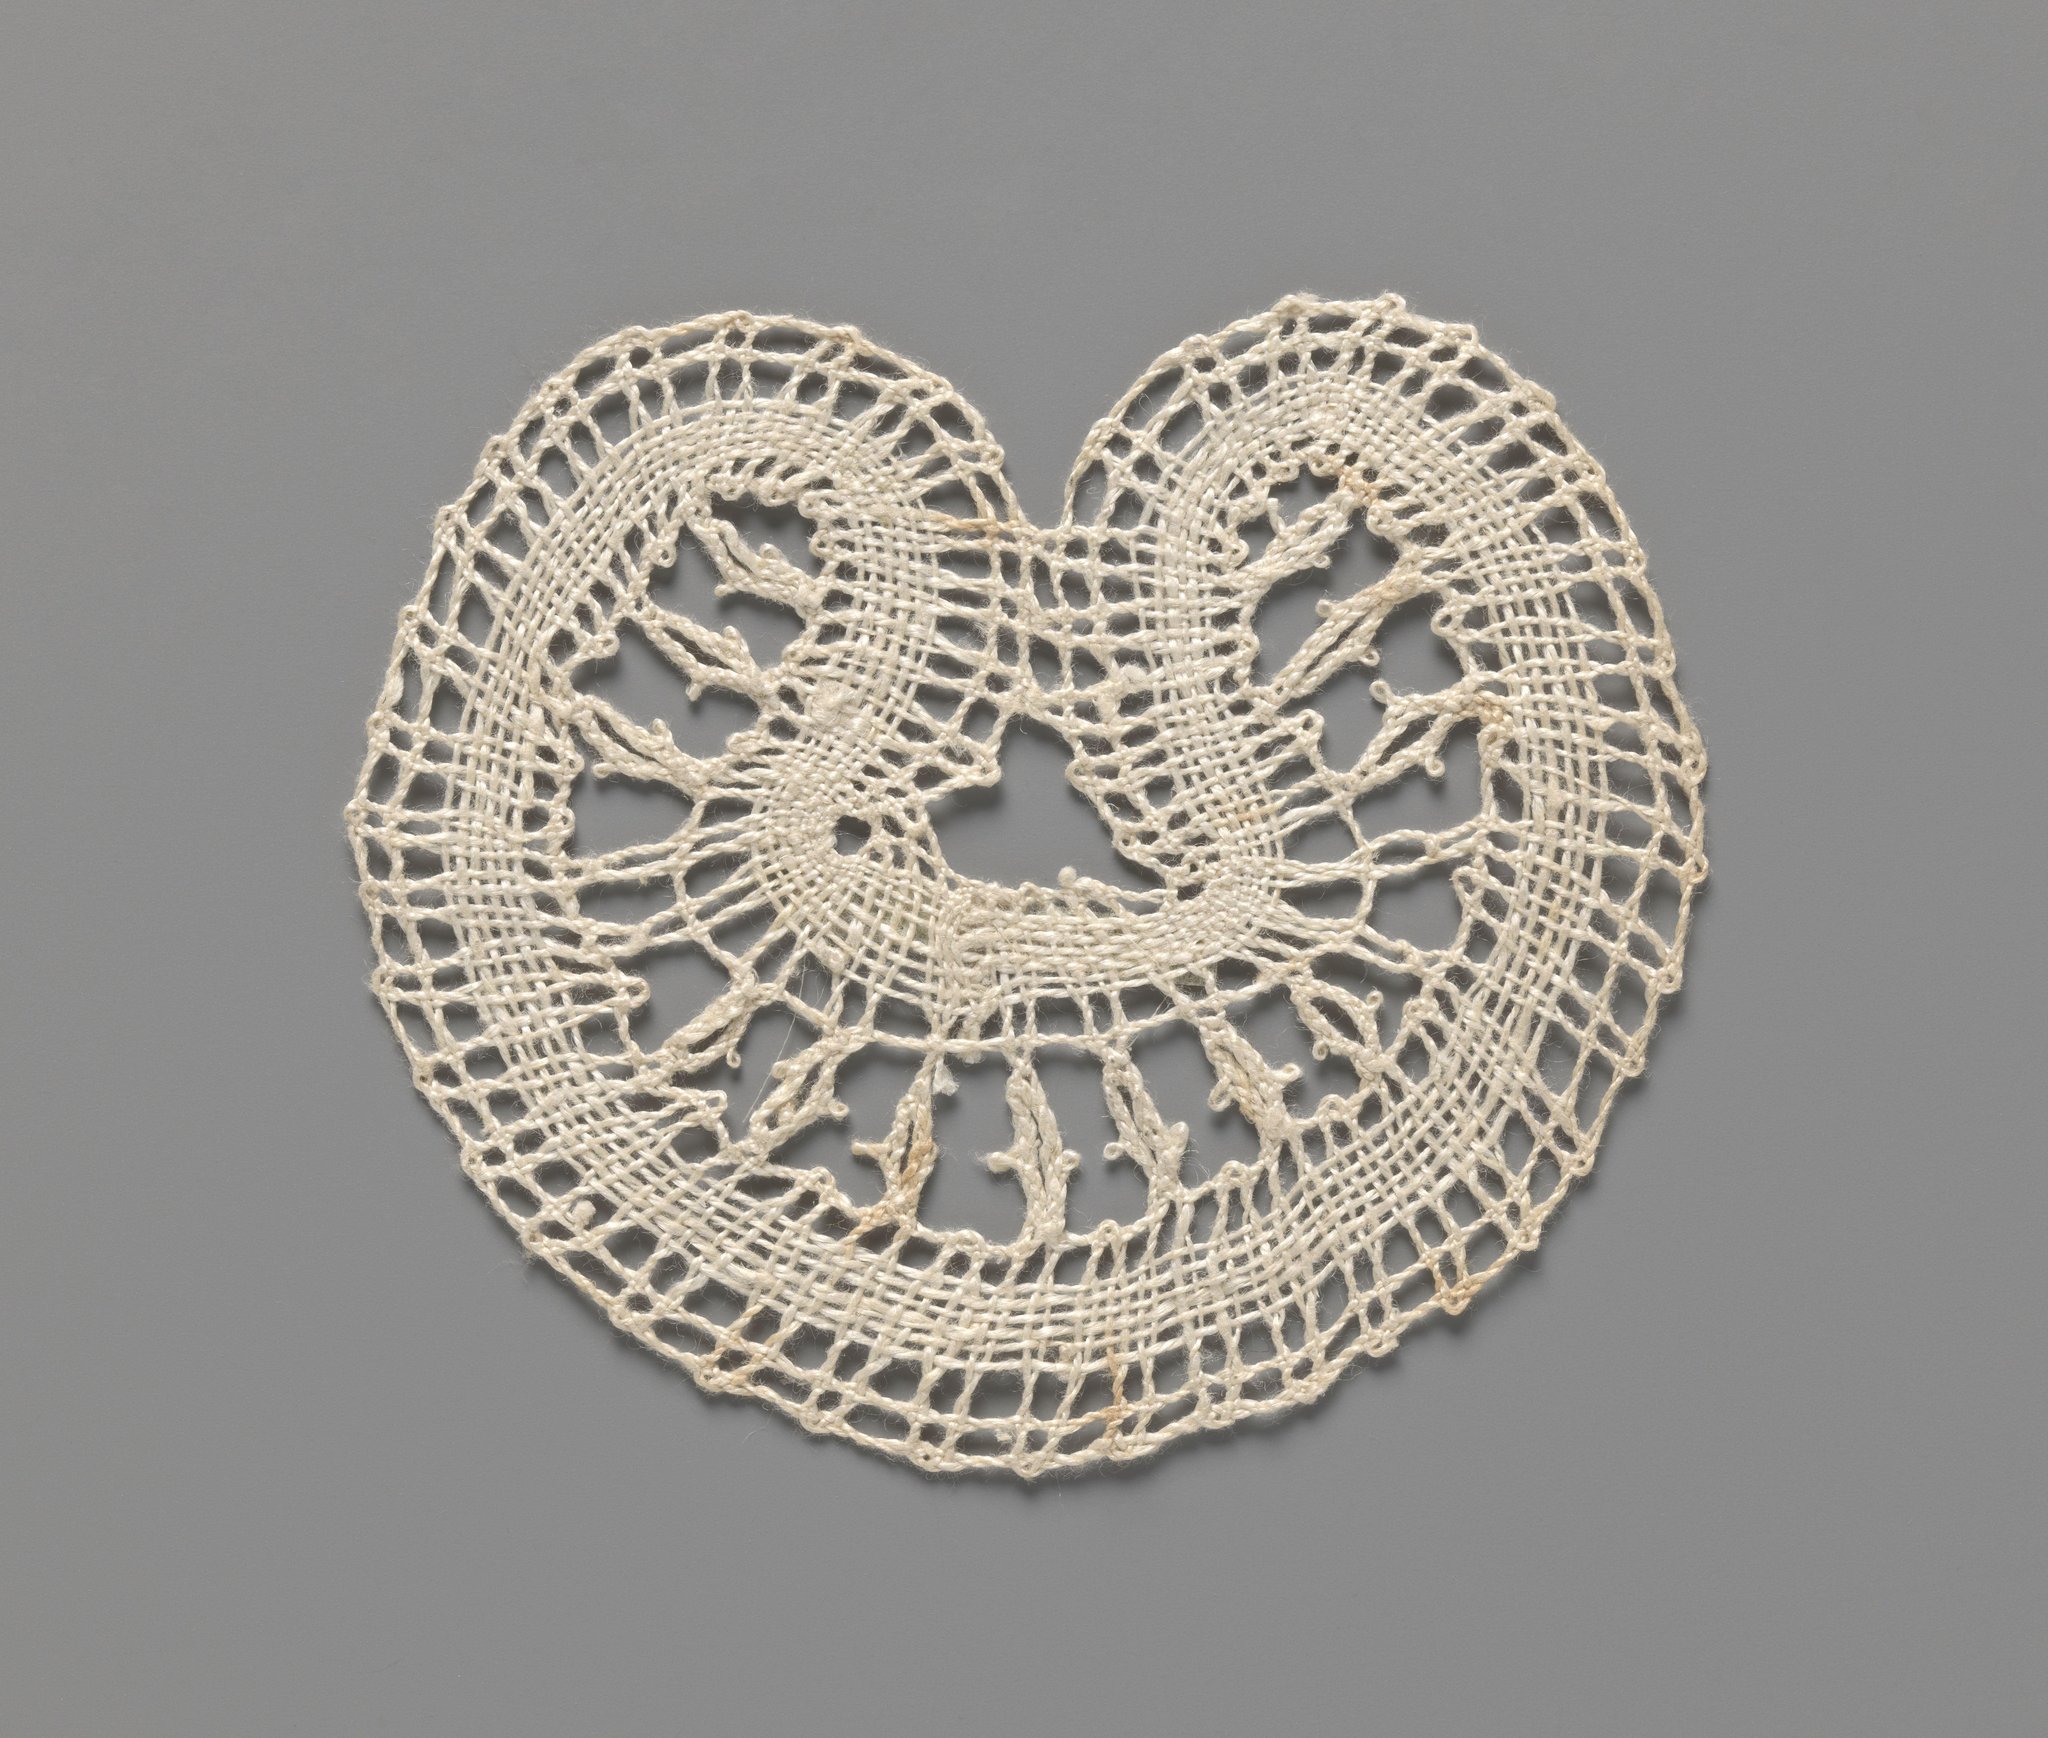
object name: motif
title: Motief van kloskant in de vorm van een nier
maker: sophia gerardine cenijn-smit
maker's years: 1876-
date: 1914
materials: linen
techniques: lace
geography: amsterdam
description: Motief in de vorm van een nier van naturelkleurig kloskant: Cluny-kant. De contour van de nier is gemaakt in linnenslag met een opengewerkte buitenrand met vlechten. Binnen de contour verbindingen met dubbele vlechten met in het midden van elk vlechtje steeds één picot.